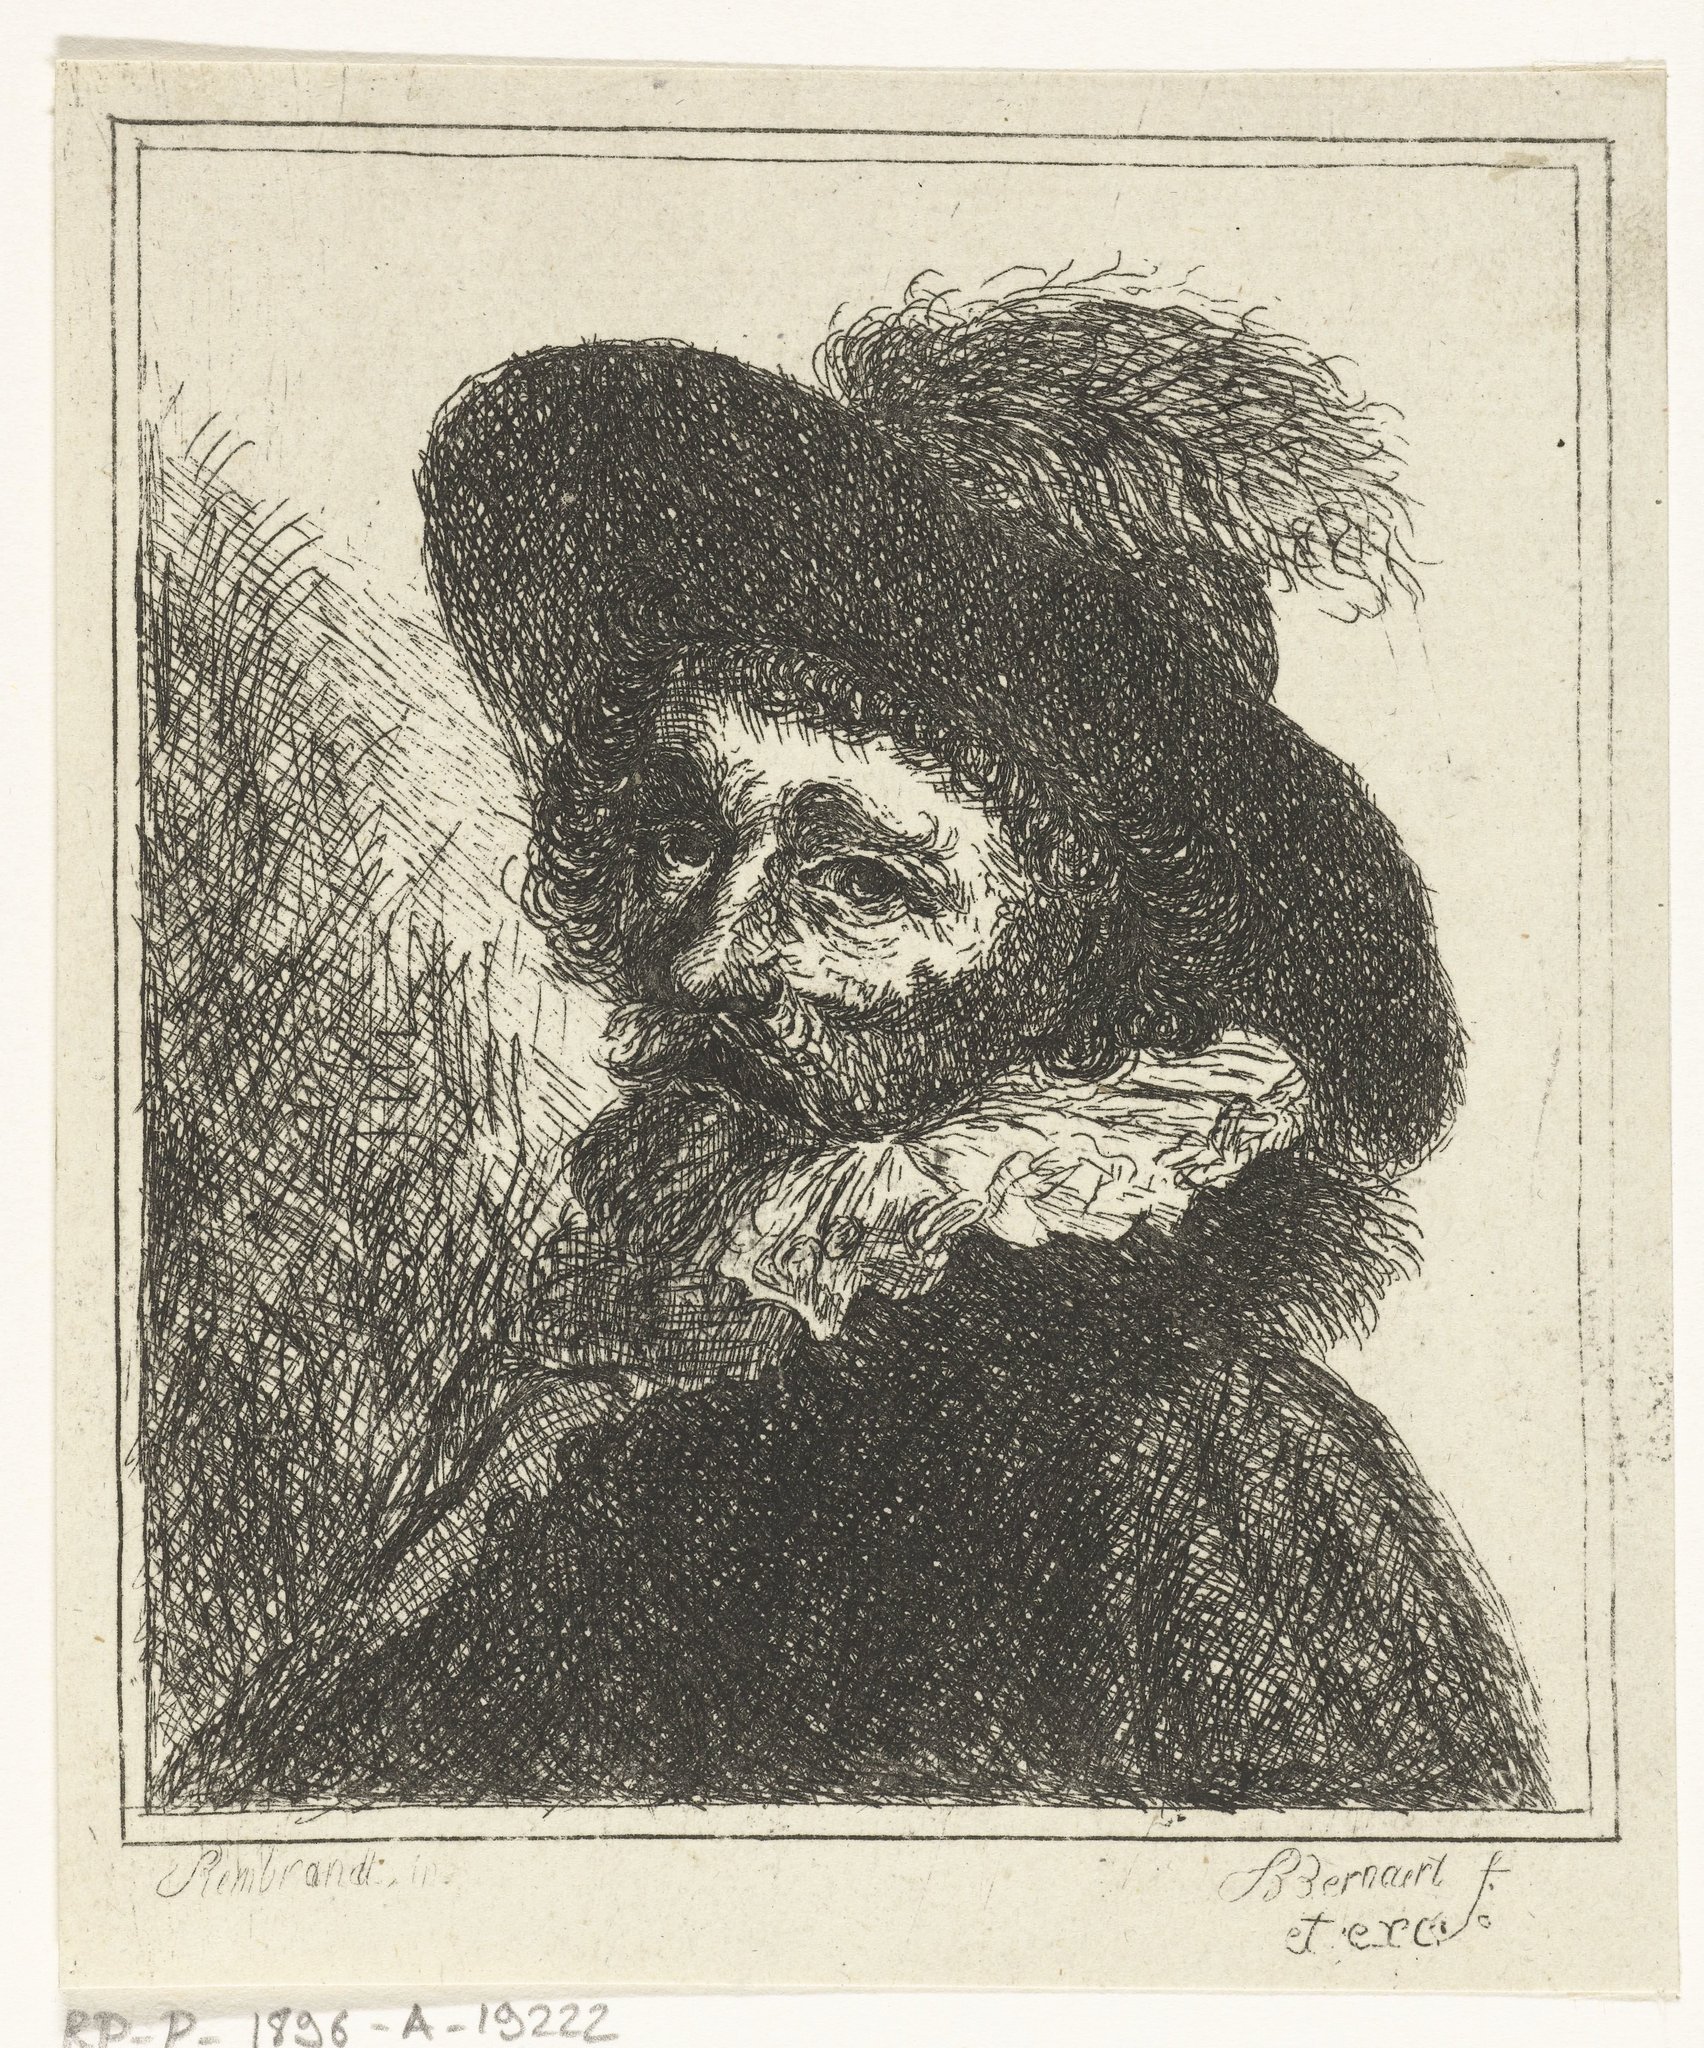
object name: print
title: Mansportret met hoed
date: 1775-1800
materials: paper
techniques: etching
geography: netherlands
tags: anonymous historical person portrayed alone, head-gear: hat (+ men's clothes)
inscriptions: collector's mark: Lugt 2228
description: Portretbuste van een man met sik en baard. De man draagt een hoed met een pluim en een witte plooikraag.